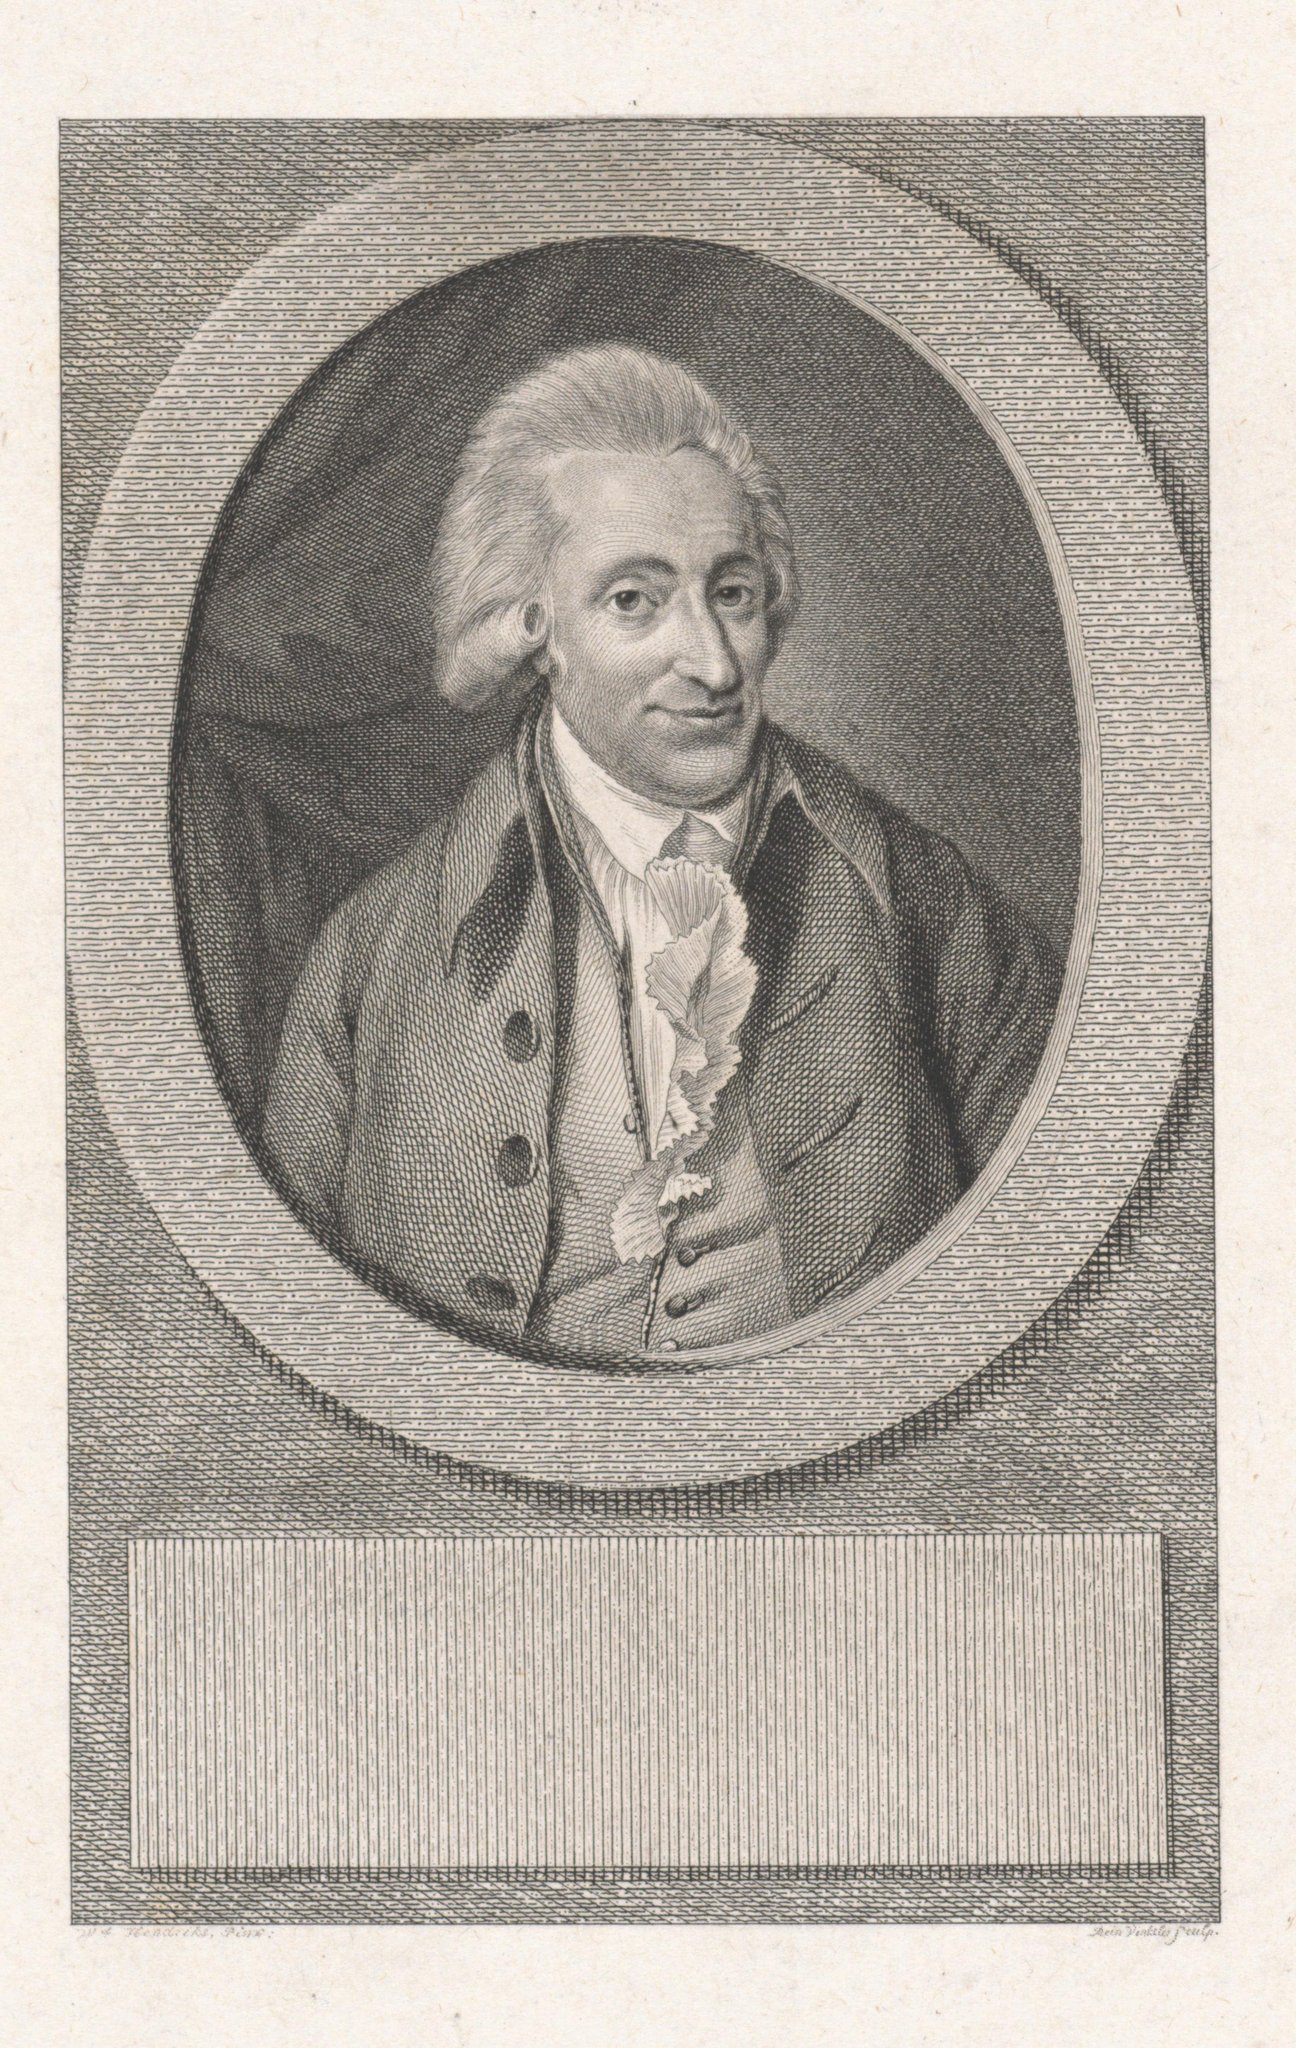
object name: print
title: Portret van Hendrik Albert Schultens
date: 1786-1809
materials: paper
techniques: engraving, etching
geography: amsterdam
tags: leiden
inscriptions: collector's mark: Lugt 240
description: Latere staat prent ook gebruikt als boekillustratie in: Wagenaar, Jan. Vaderlandsche historie, (...) ten vervolge van Wagenaars Vaderlandsche historie. Dl. 1-43. Amsterdam: Johannes Allart, 1786-1809.